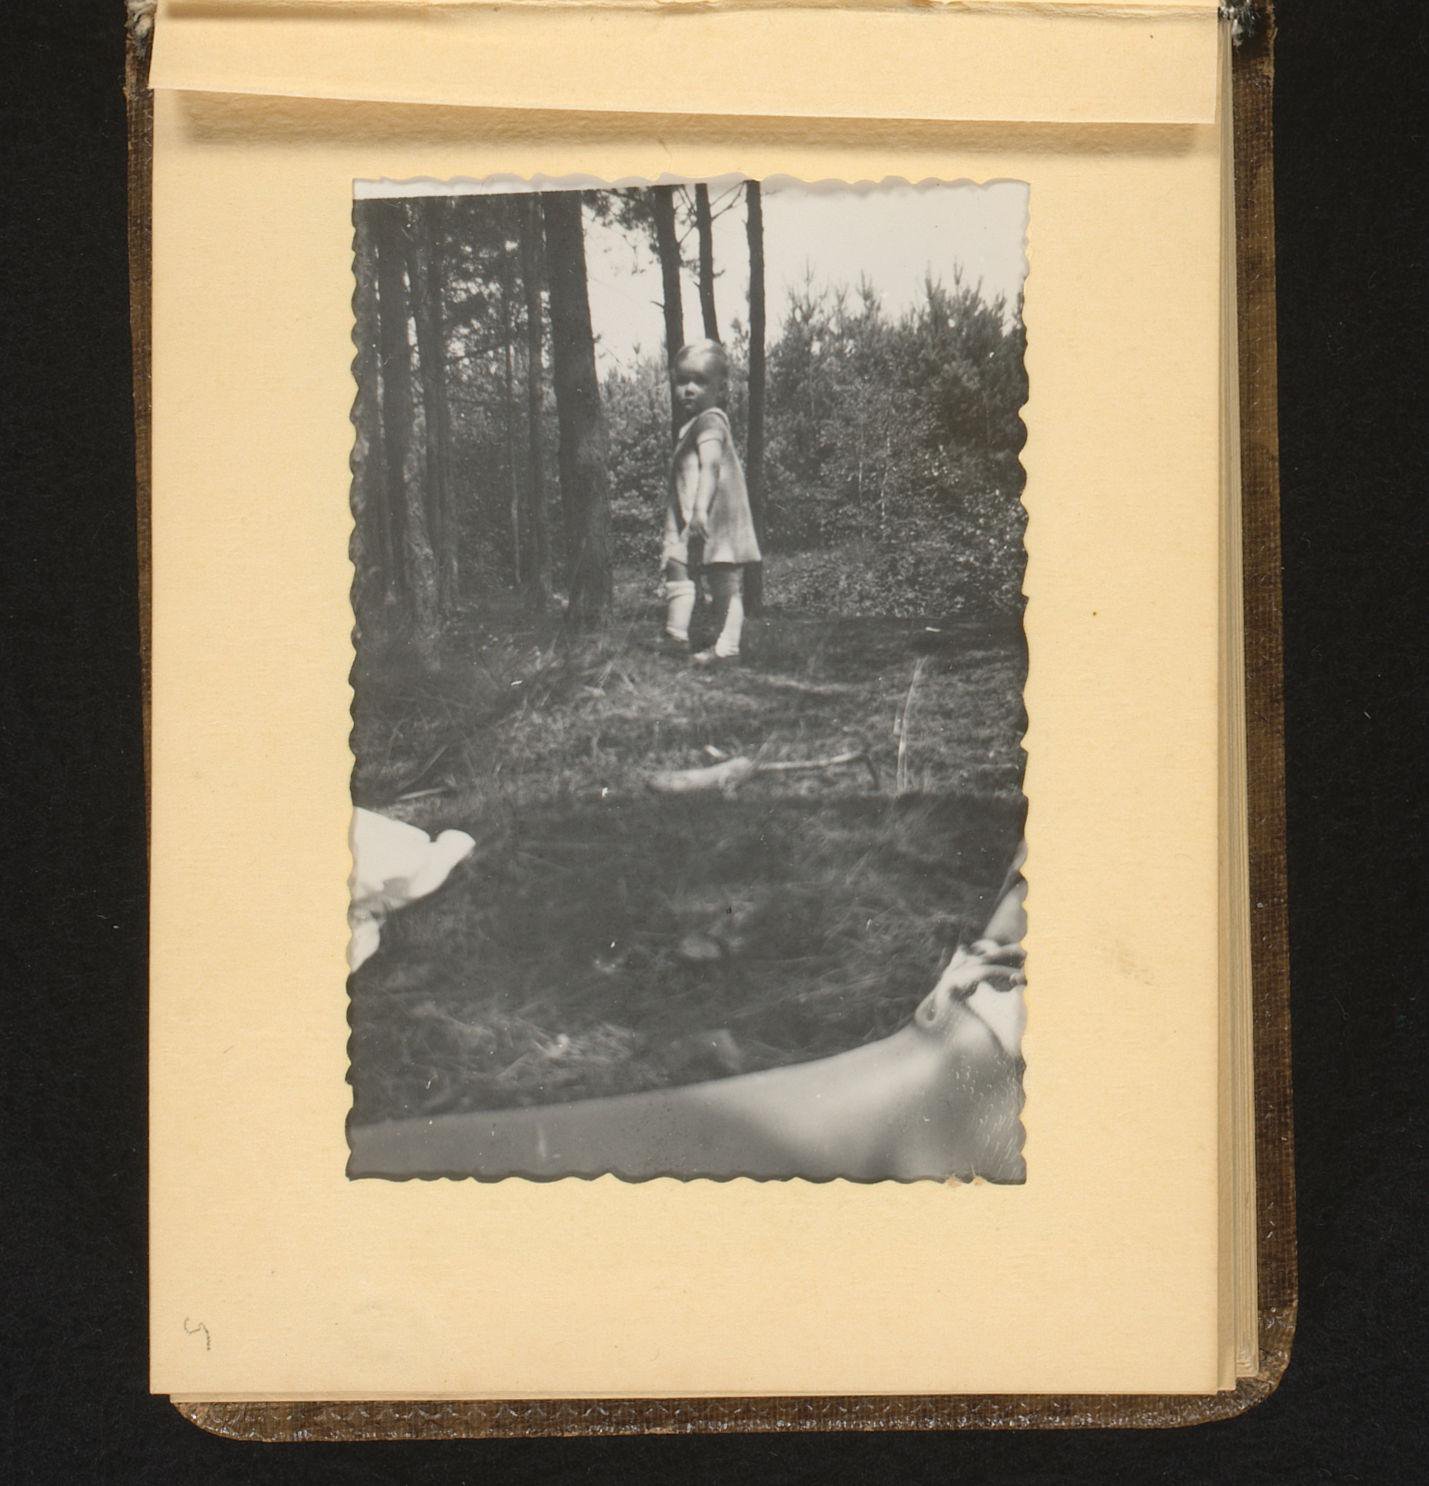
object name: photograph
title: In het bos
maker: Anonymous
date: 1938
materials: cardboard, photographic support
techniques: gelatin silver print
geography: netherlands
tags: family life at home, outing, pleasure trip, netherlands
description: Albumblad met een foto van een kind in het bos. Onderdeel van het familiealbum 1938-1939.